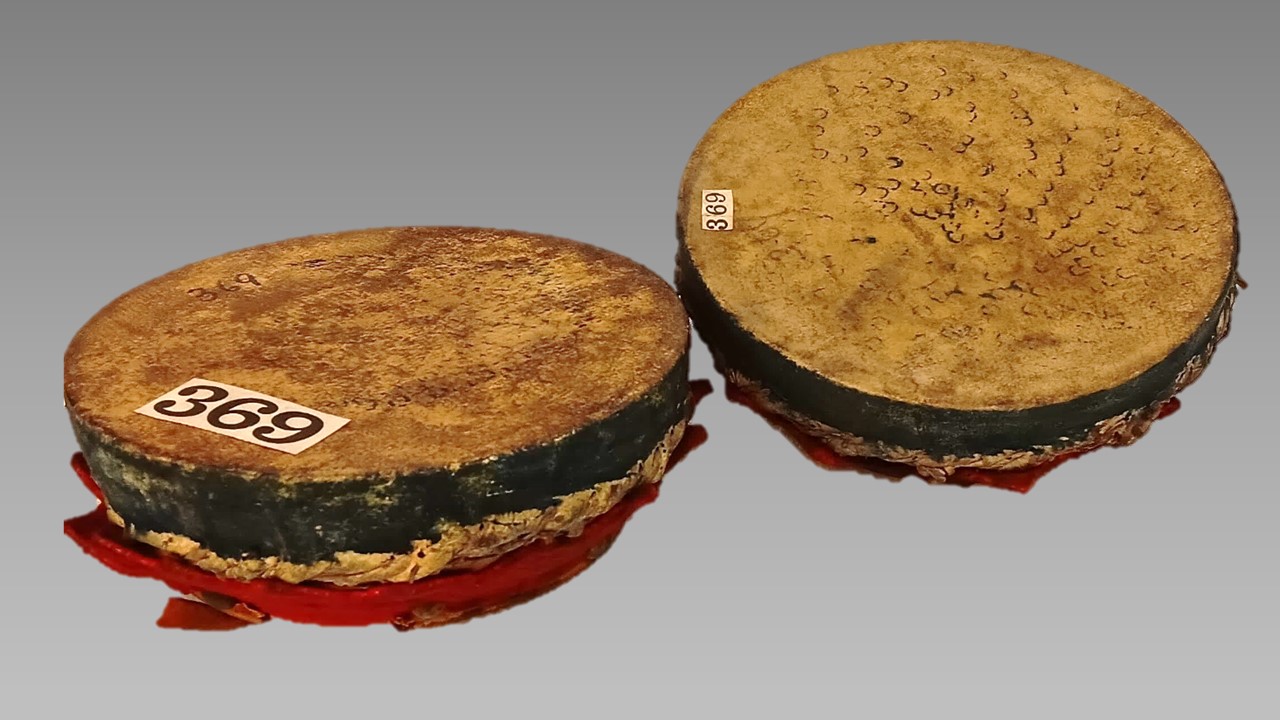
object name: tabbalat arrakeb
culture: arabian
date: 1867-1900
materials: felt, leather, metal, skin, wood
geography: arabia